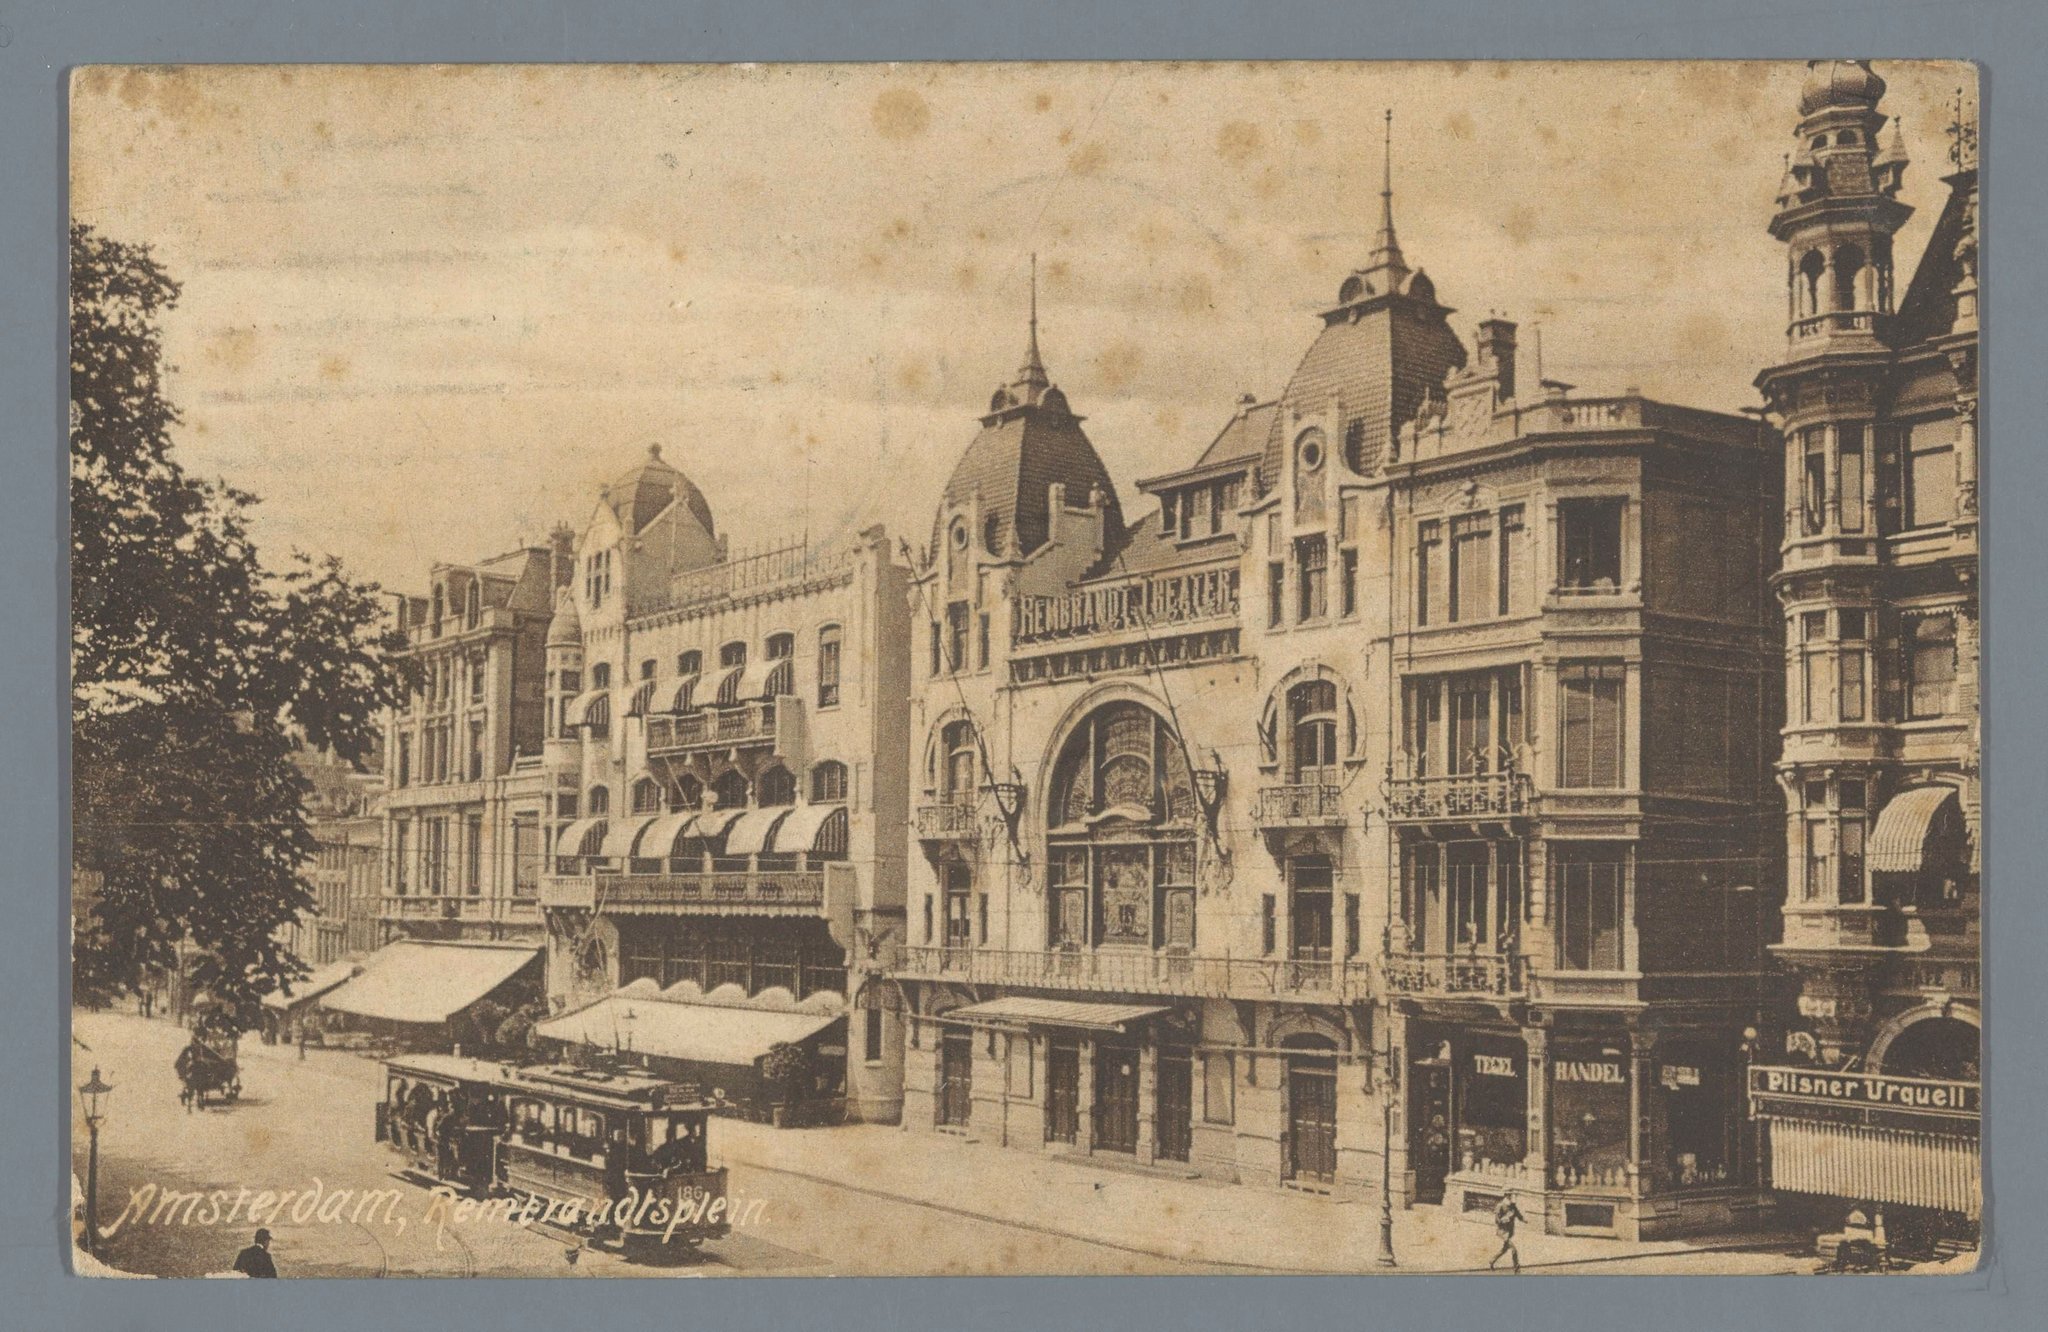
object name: ansichtkaart, prentbriefkaart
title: Amsterdam, Rembrandtsplein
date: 1911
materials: cardboard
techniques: photograph, writing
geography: amsterdam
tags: square, place, circus, etc.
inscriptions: number: ‘08 59966’, inscription: ‘Dr. Trenckler Co. Leipzig 1908. Ams. 230’